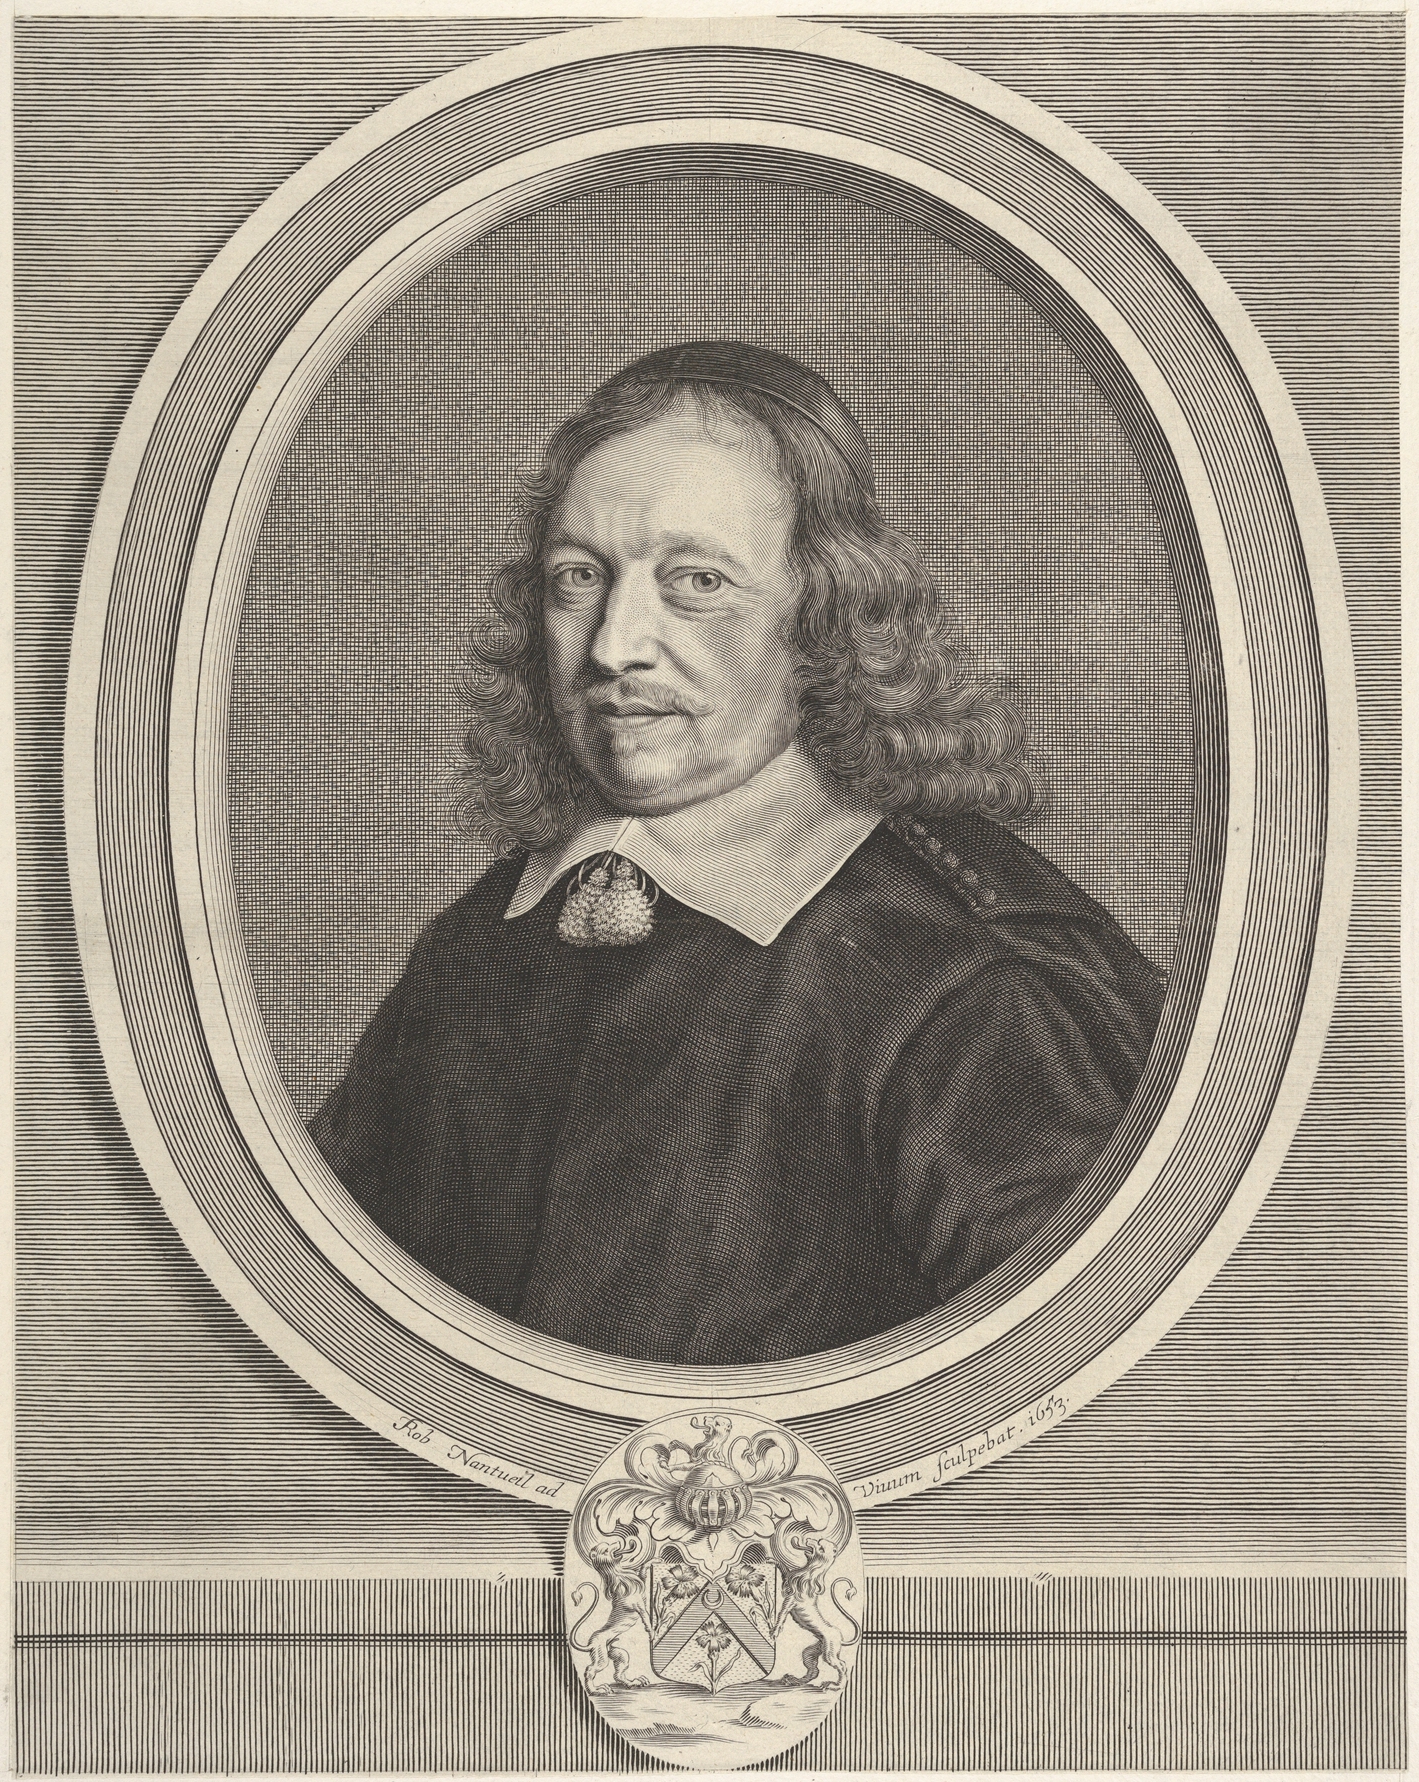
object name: print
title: Gilles Blondeau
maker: robert nanteuil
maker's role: artist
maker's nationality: french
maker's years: 1623-1678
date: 1653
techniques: engraving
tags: men,portraits,coat of arms